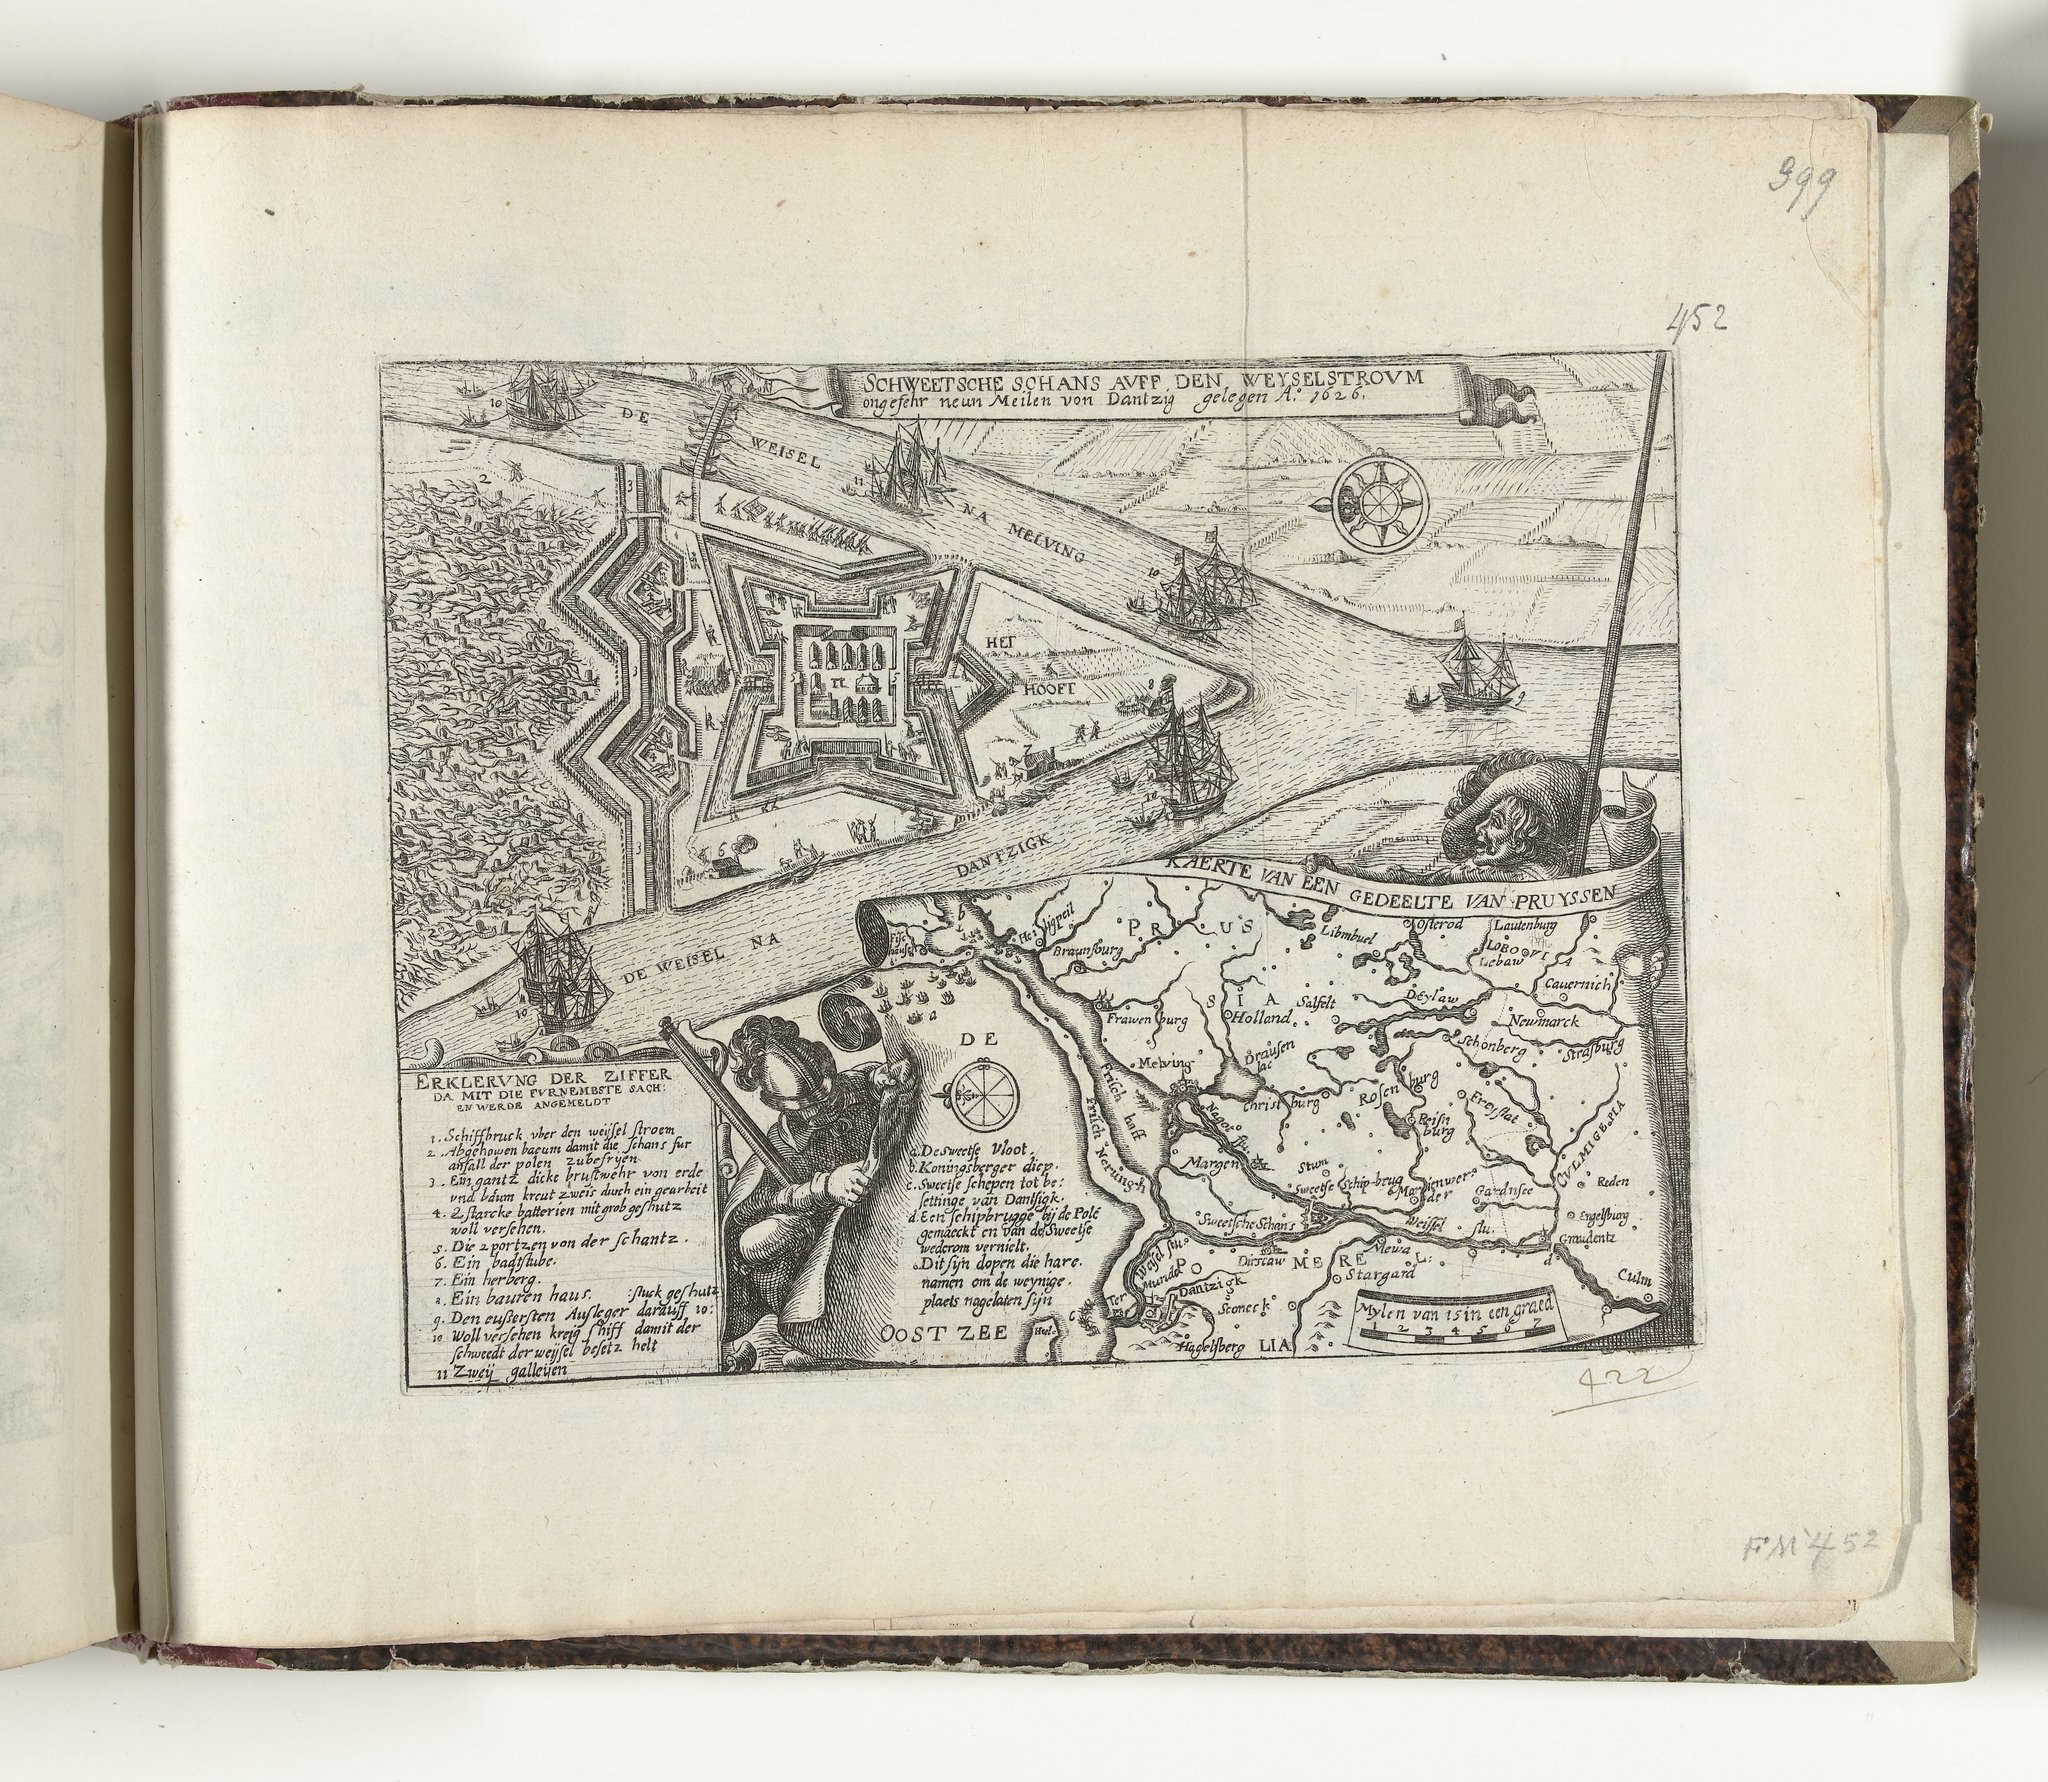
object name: print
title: Zweedse schans aan de Weichsel bij Danzig, 1626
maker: frans hogenberg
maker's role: print maker, publisher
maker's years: 1538-1590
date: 1626-1628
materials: paper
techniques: etching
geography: cologne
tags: fortifications, military engineering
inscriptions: inscription: ‘422’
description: Zweedse schans gebouwd aan de Weichsel bij Danzig, 1626. Onderaan een cartouche in de vorm van een rol papier opgehouden door twee soldaten met een kaart van de monding van de Weichsel met titel en bijschriften in het Nederlands. Links Legenda van de hoofdvoorstelling 1-11. Rechtsonder met pen genummerd: 422. De prent maakt deel uit van een album.